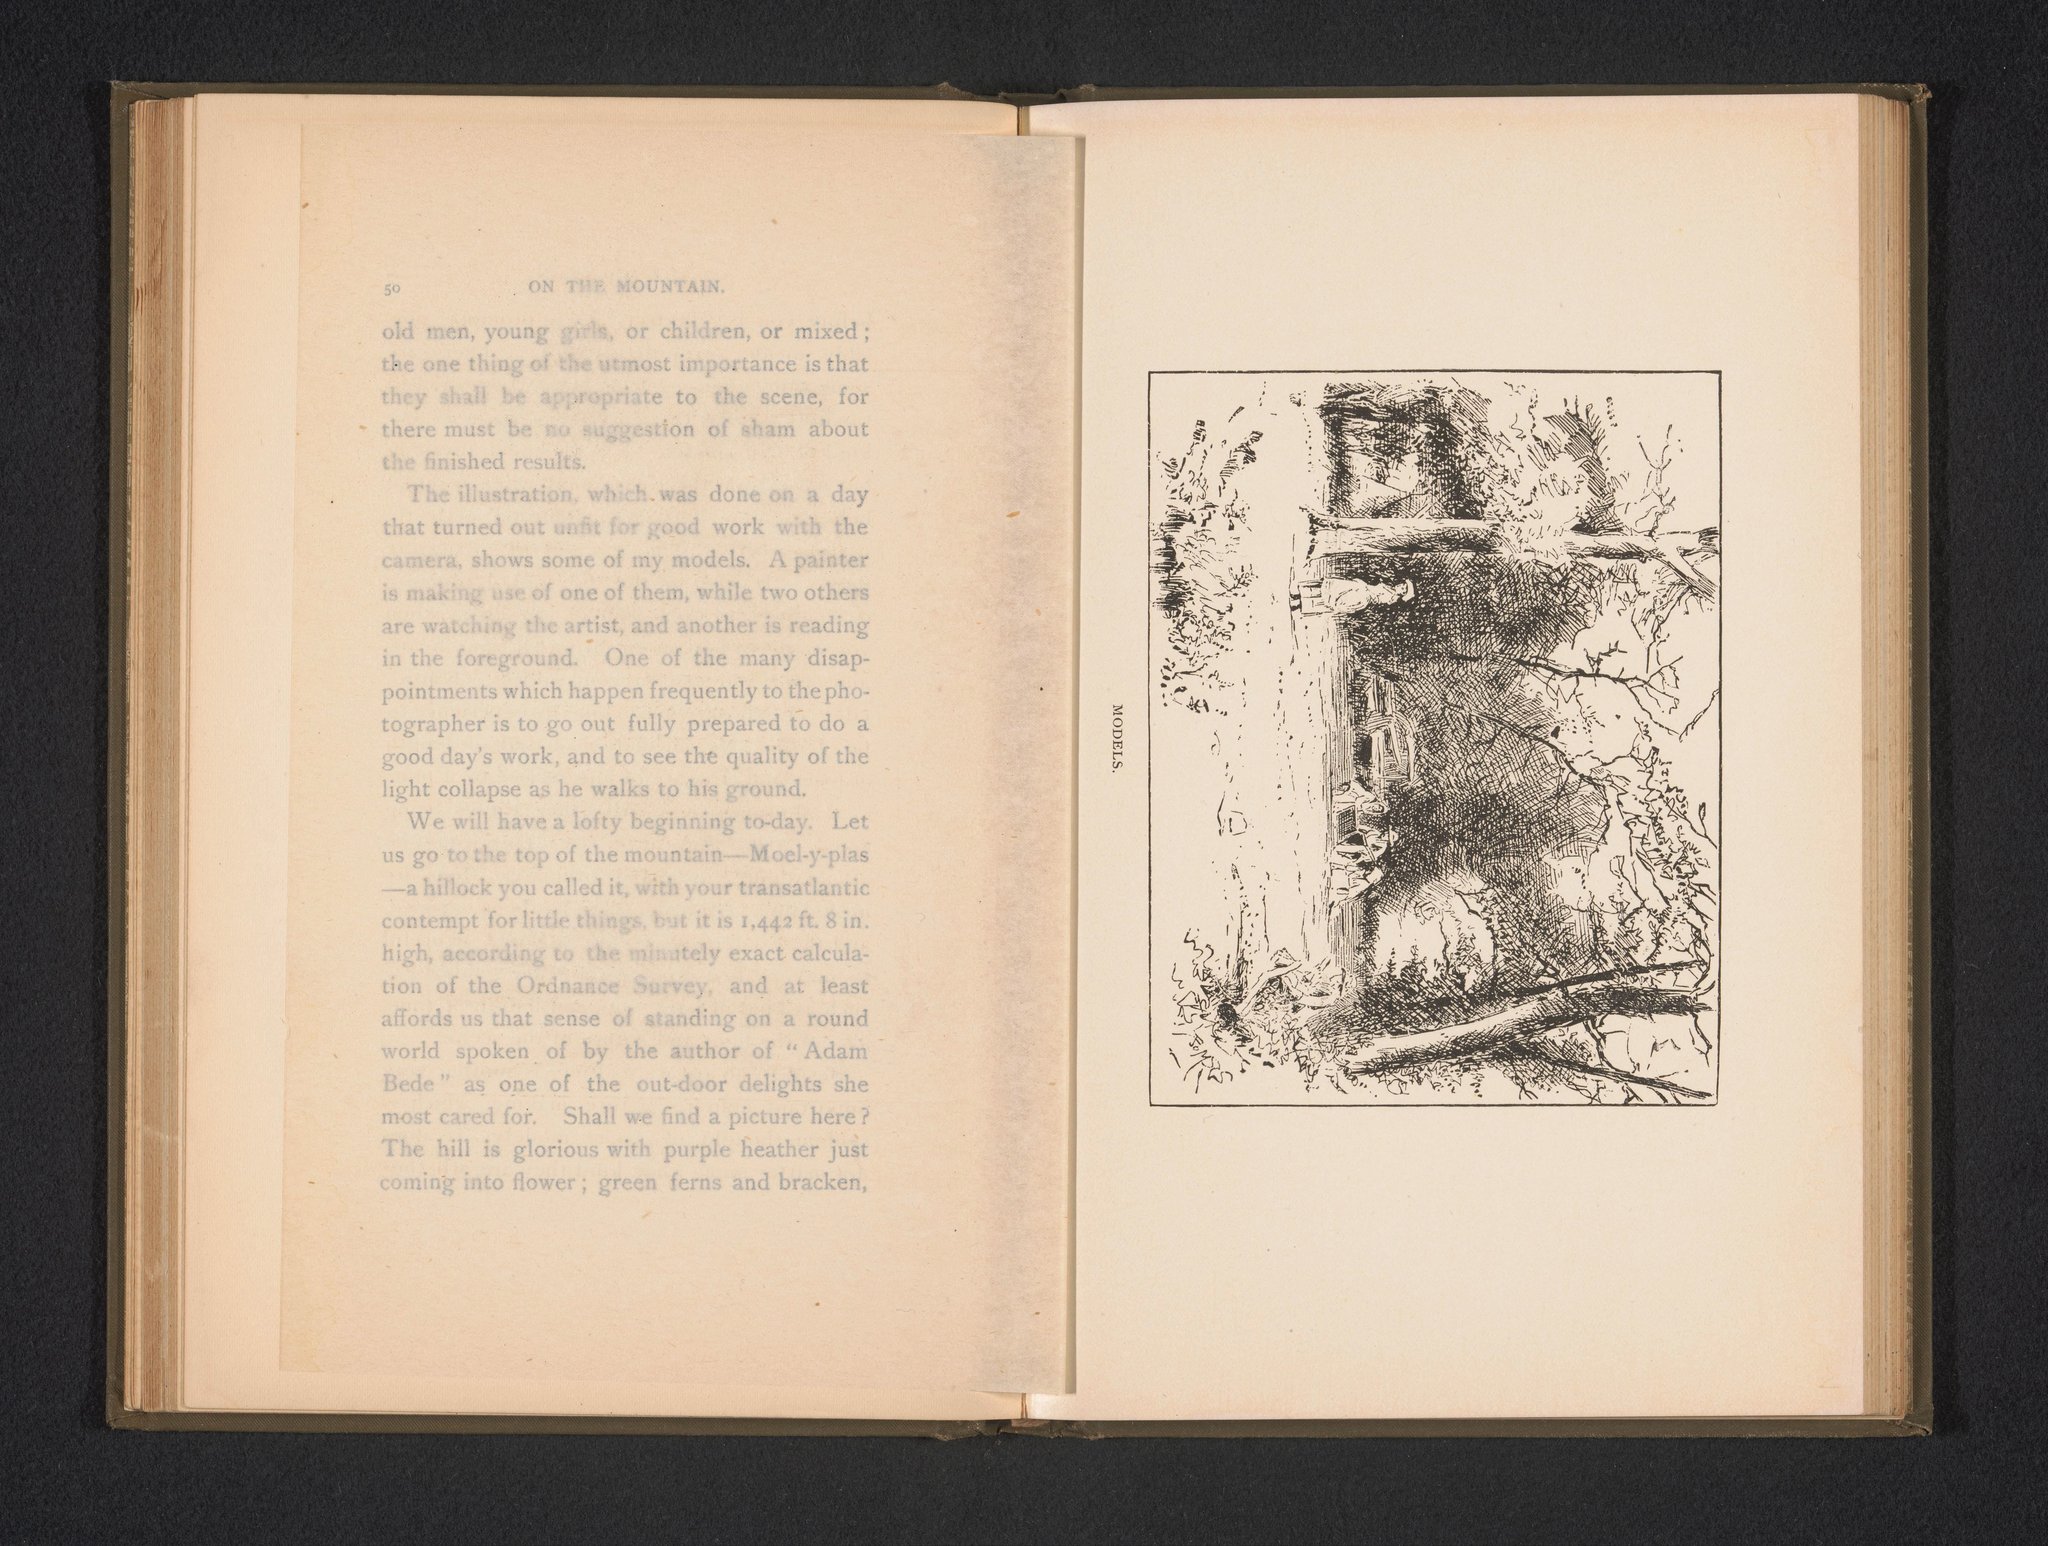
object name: photomechanical print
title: Models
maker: Anonymous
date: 1883-1888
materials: paper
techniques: autotype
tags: landscapes, historical persons (portraits and scenes from the life)